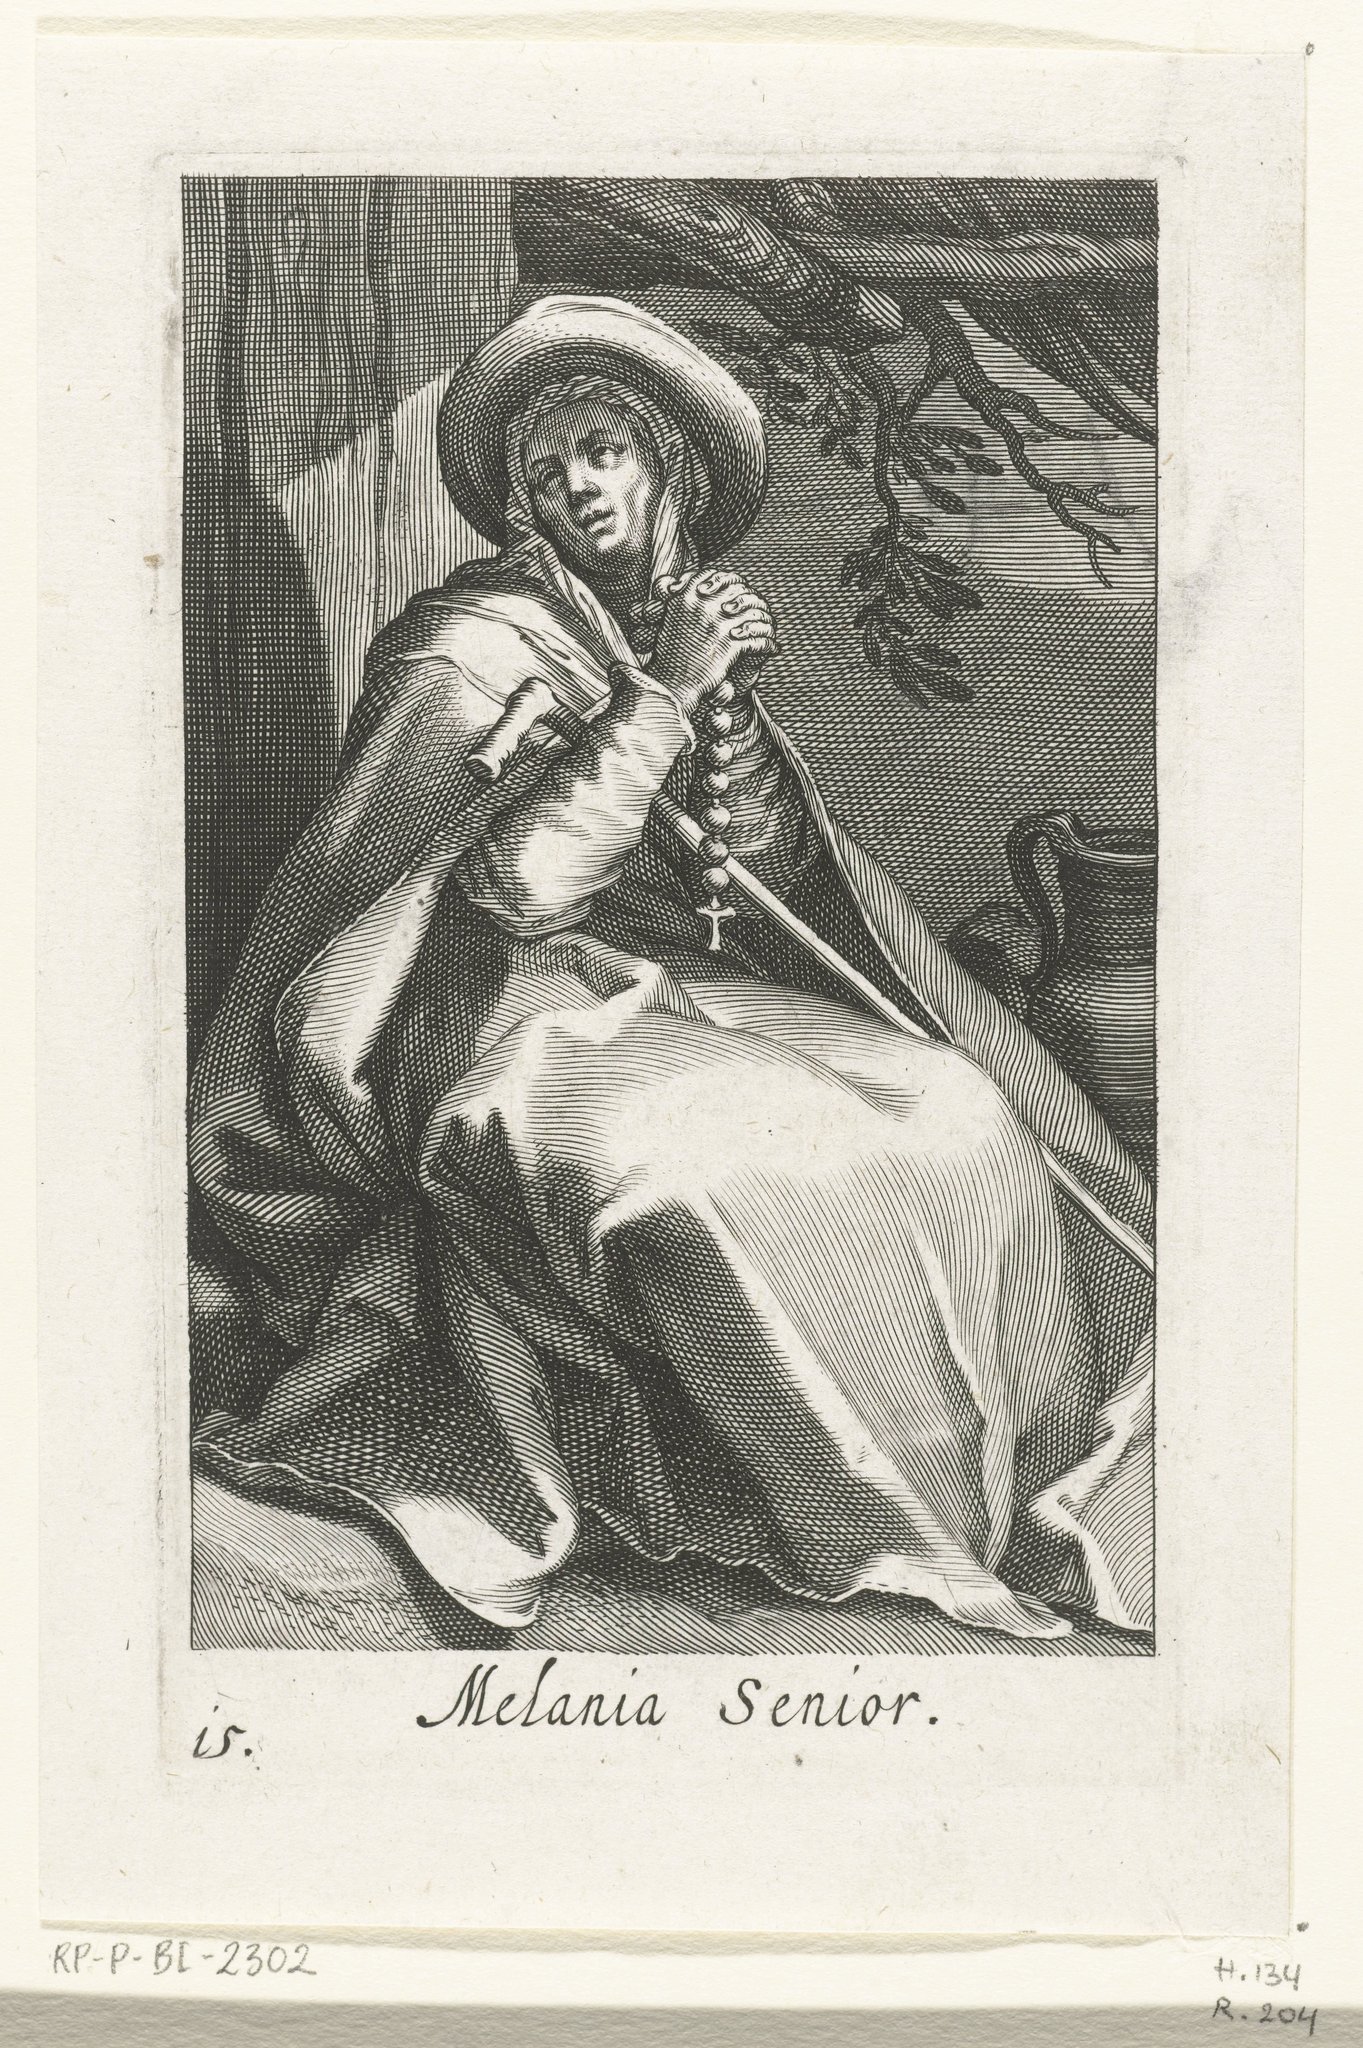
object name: book illustration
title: Heilige Melania de Oudere als kluizenares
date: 1590-1612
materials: paper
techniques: engraving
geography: amsterdam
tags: anchorite, hermit, female saints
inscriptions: collector's mark: Lugt 2228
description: Prent uit: Sacra Eremus Ascetriarum, uitgever Boëtius Adamsz. Bolswert, 1612 of Hendrik Aertssen, Antwerpen 1619. Prent uit de serie van vijfentwintig kluizenaressen in deze uitgaven. In 1612 verscheen een ongebonden editie maar op basis van de gewijzigde opschriften en samenstelling van de serie kluizenaars wordt aangenomen dat de prenten van de uitgave 1619 ook in 1612 of iets daarvoor gedrukt werden. De serie kluizenaressen bleef vrijwel ongewijzigd in de ongebonden uitgave van 1612, dit compliceert de datering van de losse bladen in de collectie van het RMA, zie Roethlisberger 1993, p. 171-175.